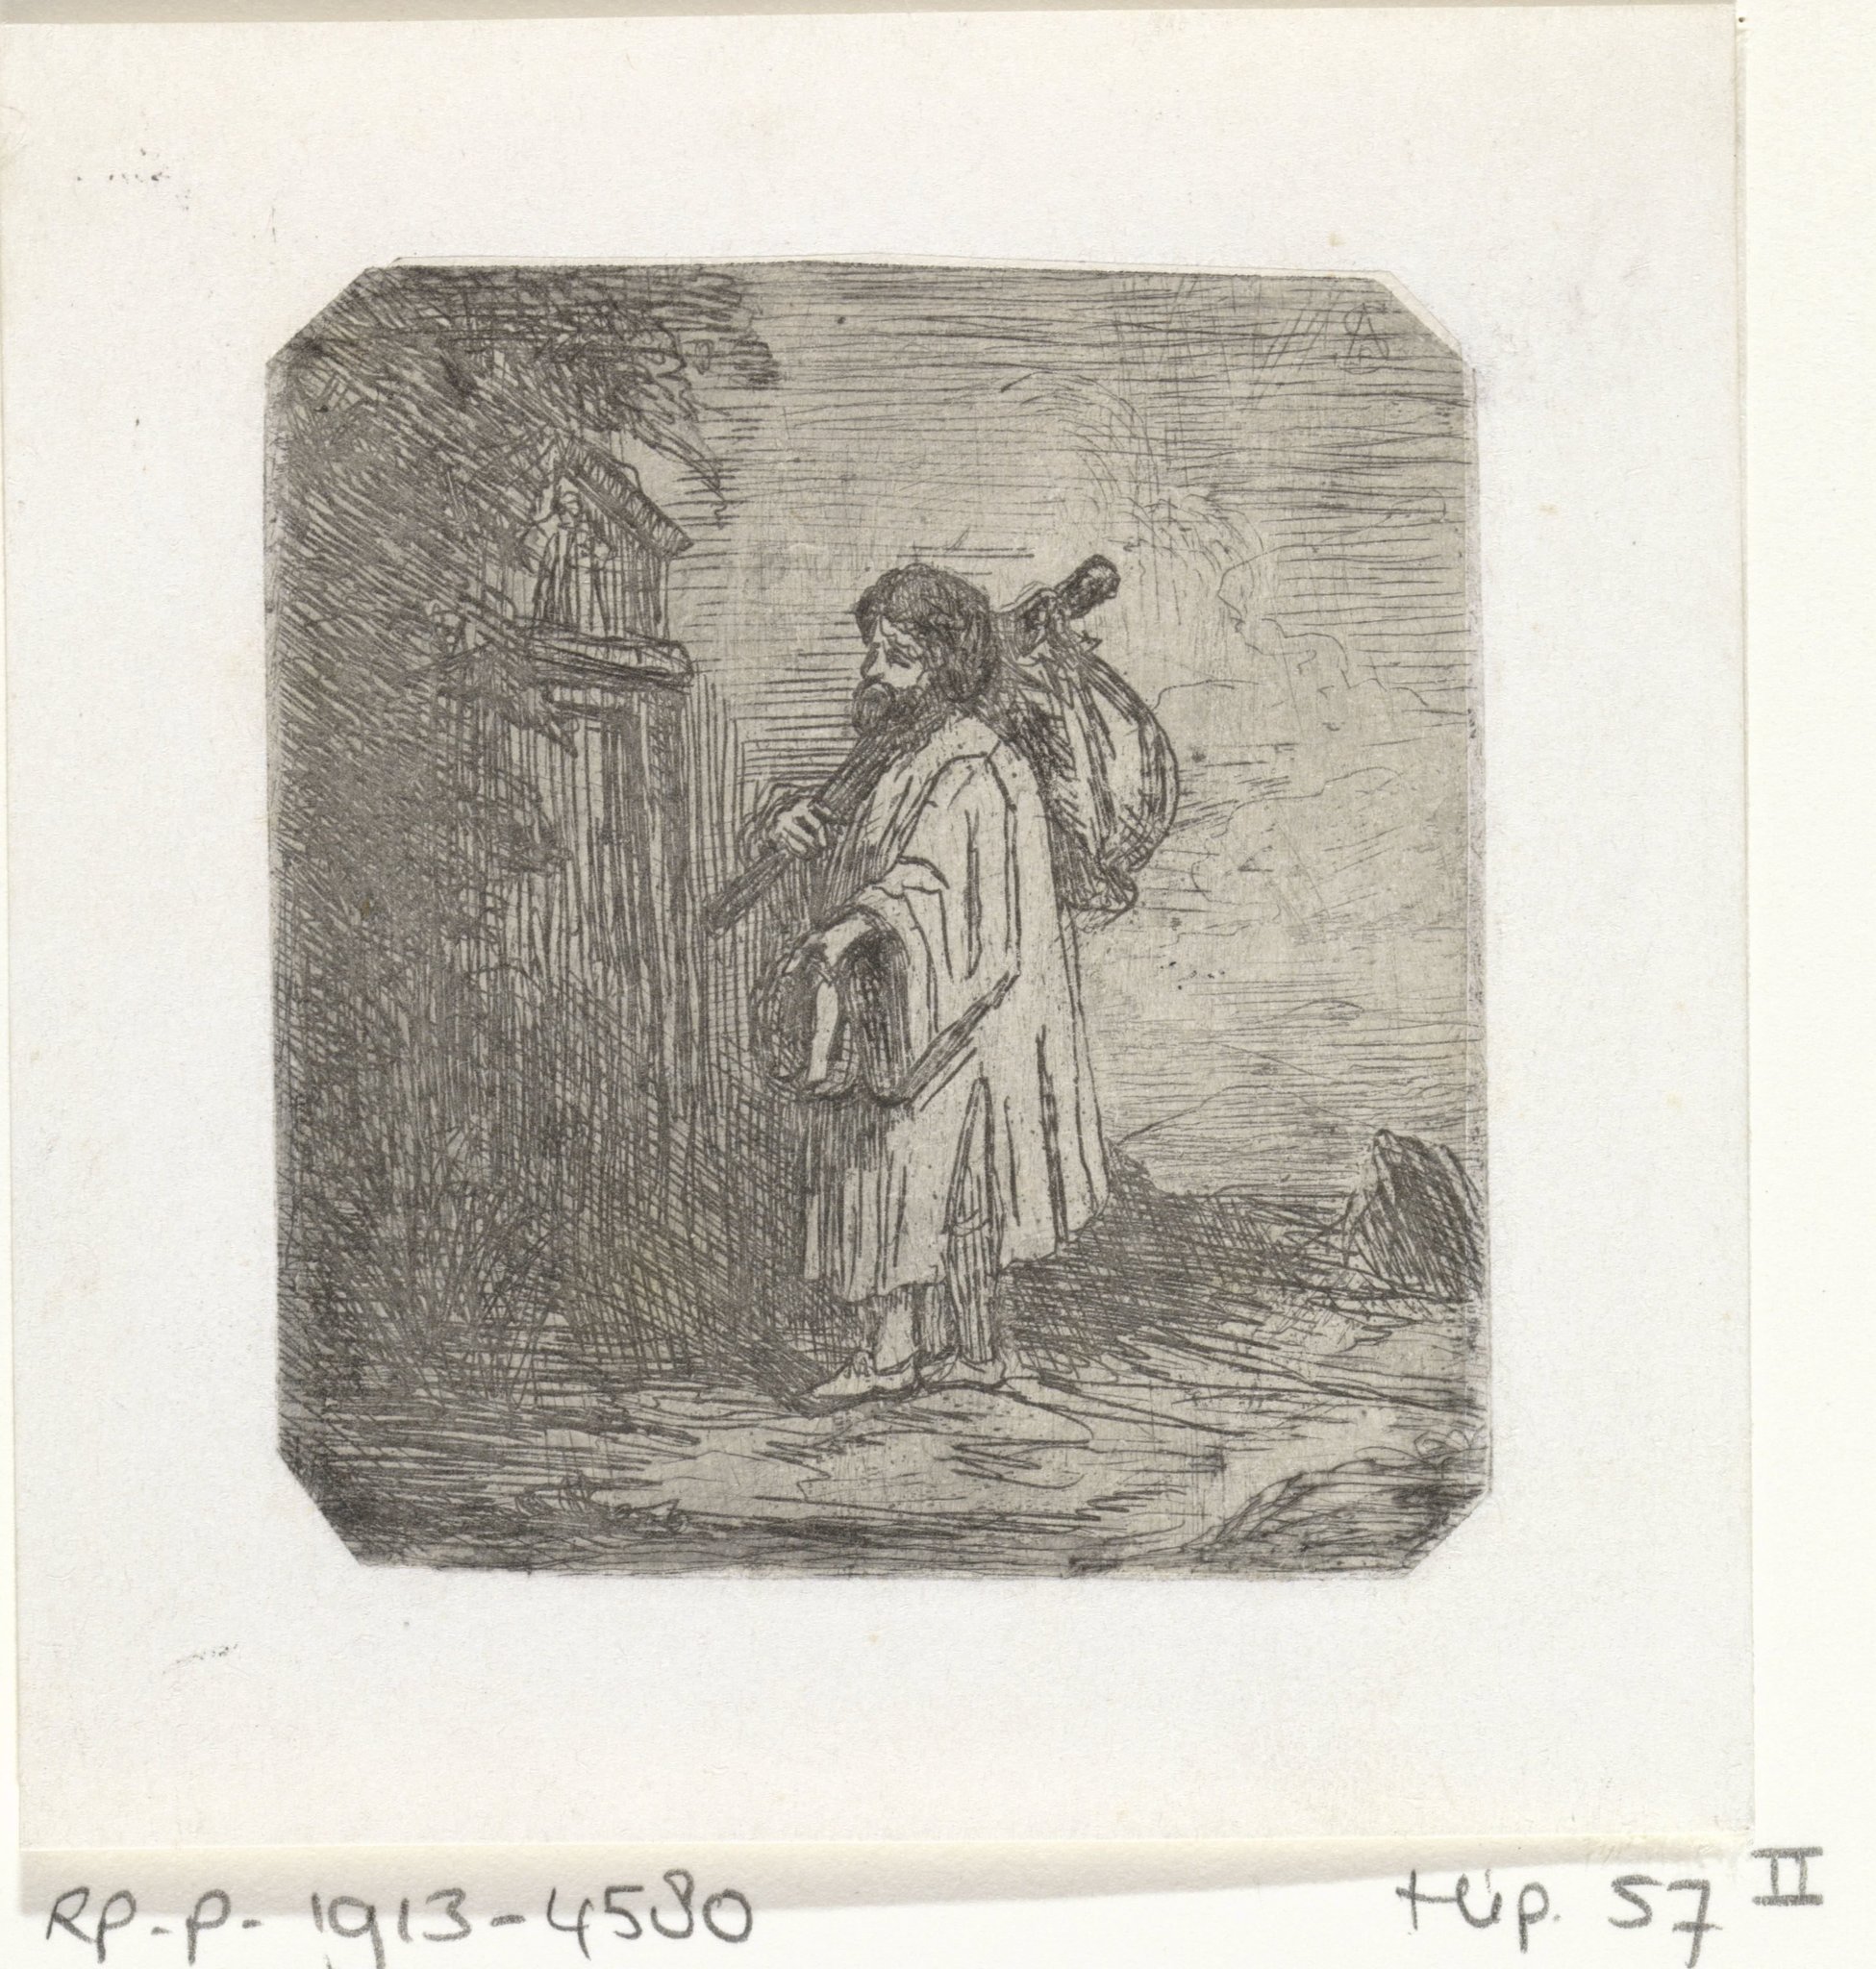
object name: print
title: Pelgrim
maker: arnoud schaepkens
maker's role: print maker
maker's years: 1816-1904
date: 1831-1904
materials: paper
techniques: drypoint, etching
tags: pilgrim(s)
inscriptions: collector's mark: Lugt 1485, collector's mark: Lugt 2228